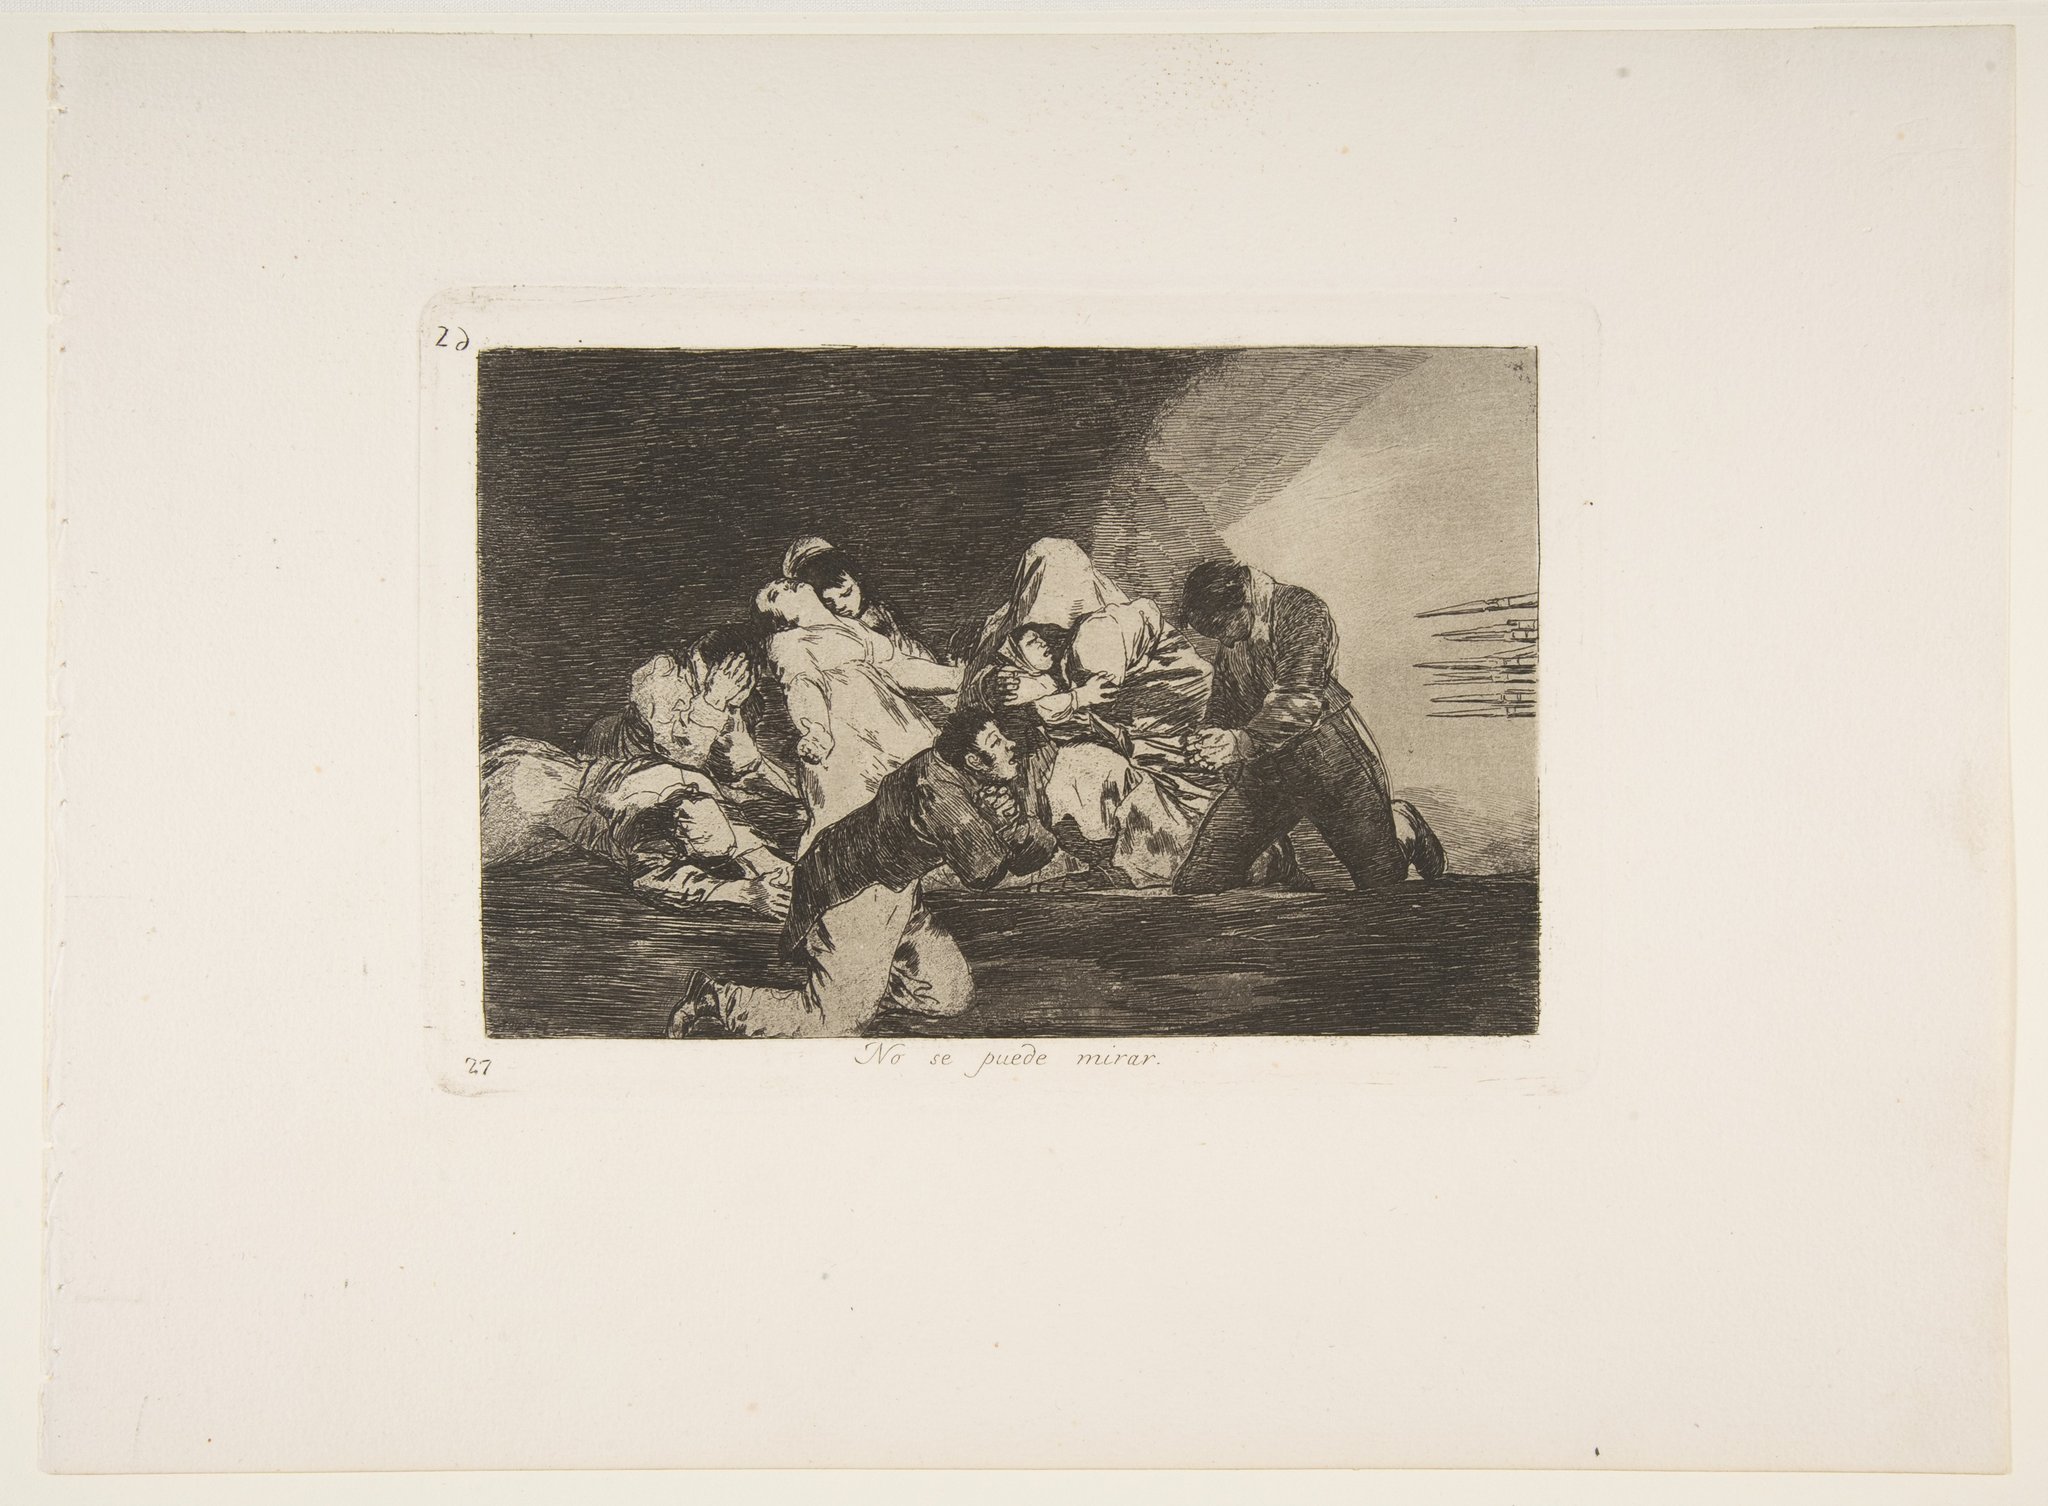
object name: print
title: Plate 26 from "The Disasters of War" (Los Desastres de la Guerra): 'One can't look' (No se puede mirar)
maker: goya (francisco de goya y lucientes)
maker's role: artist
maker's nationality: spanish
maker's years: 1746-1828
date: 1810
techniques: engraving, burnishing, drypoint, etching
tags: men,women